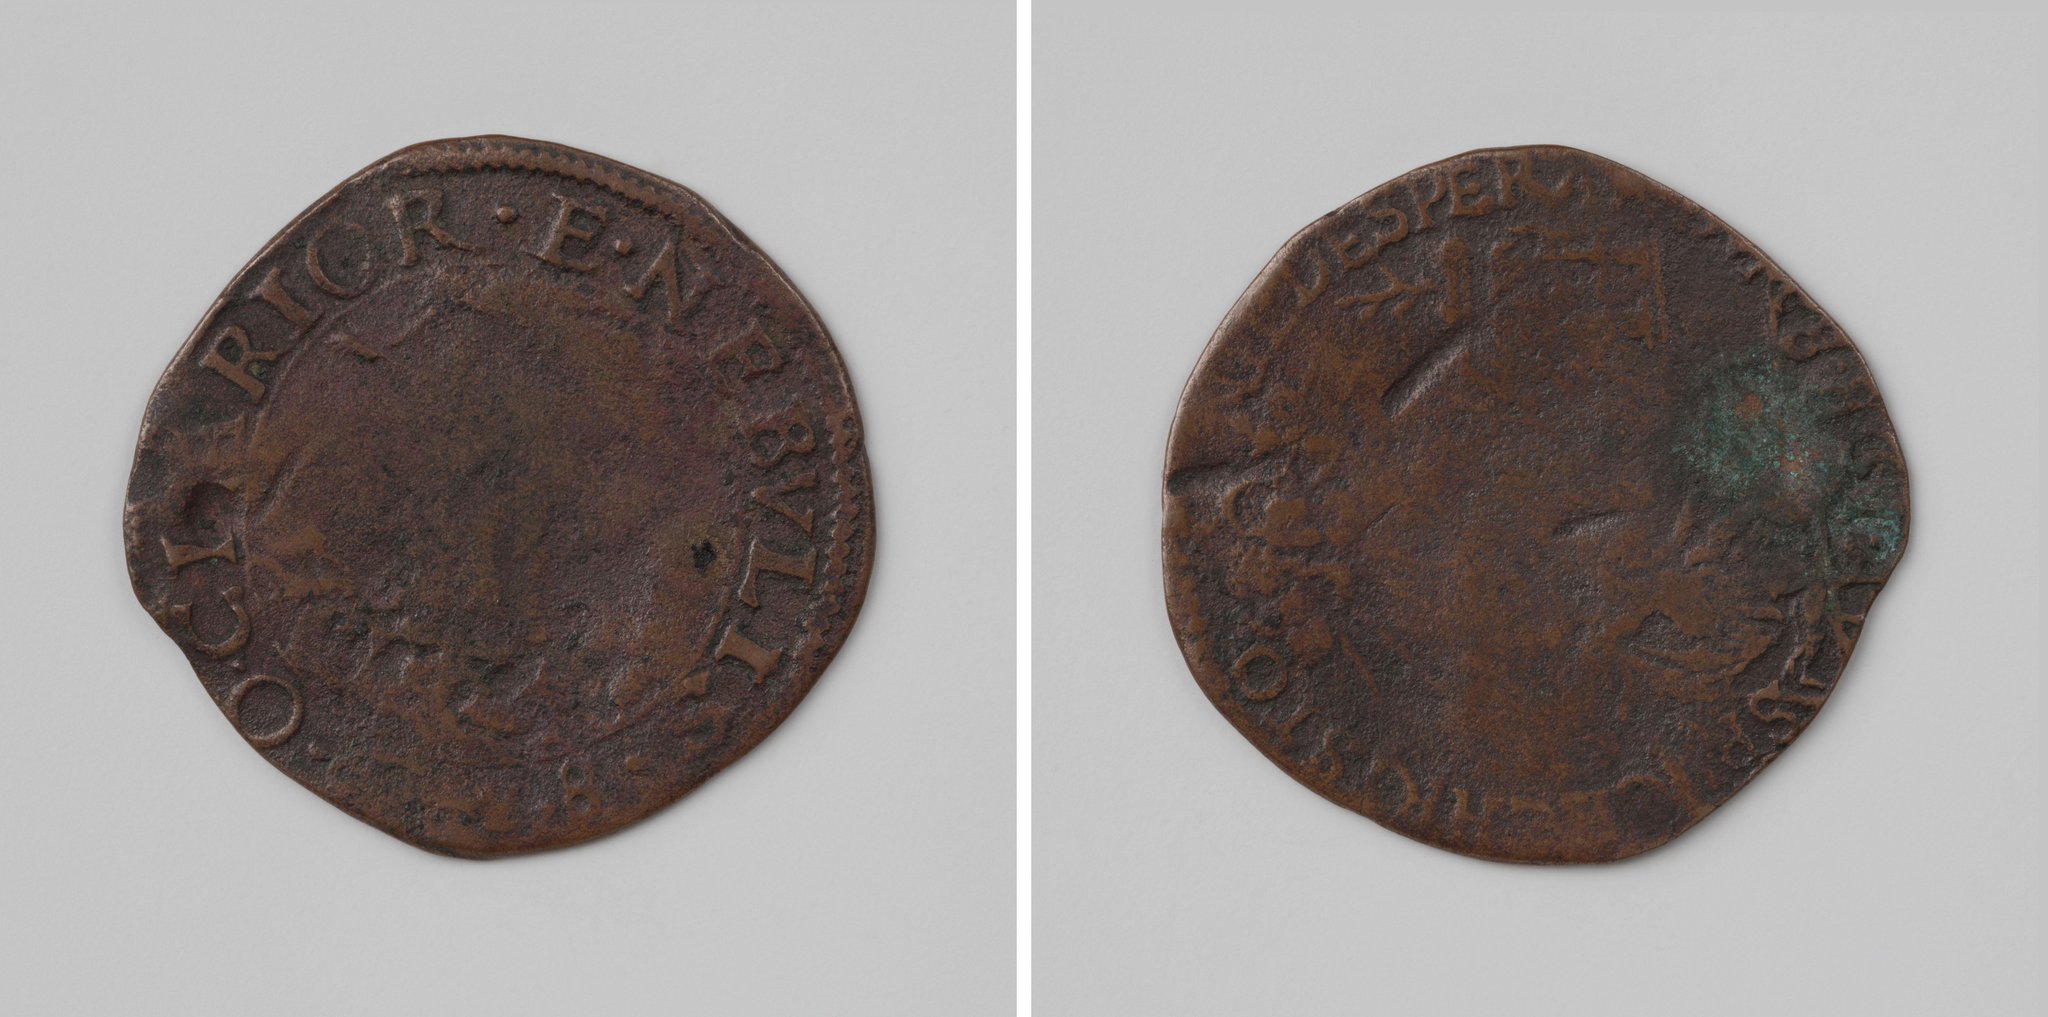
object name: jeton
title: Allegorie op de nederlagen der Spanjaarden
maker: Anonymous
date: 1589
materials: copper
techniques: striking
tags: tachtigjarige oorlog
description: Koperen penning. Voorzijde: man, op knieen biddend bij altaar tot God, die in wolken verschijnt binnen omschrift. Keerzijde: stralende zon, die wolken verdrijft binnen omschrift